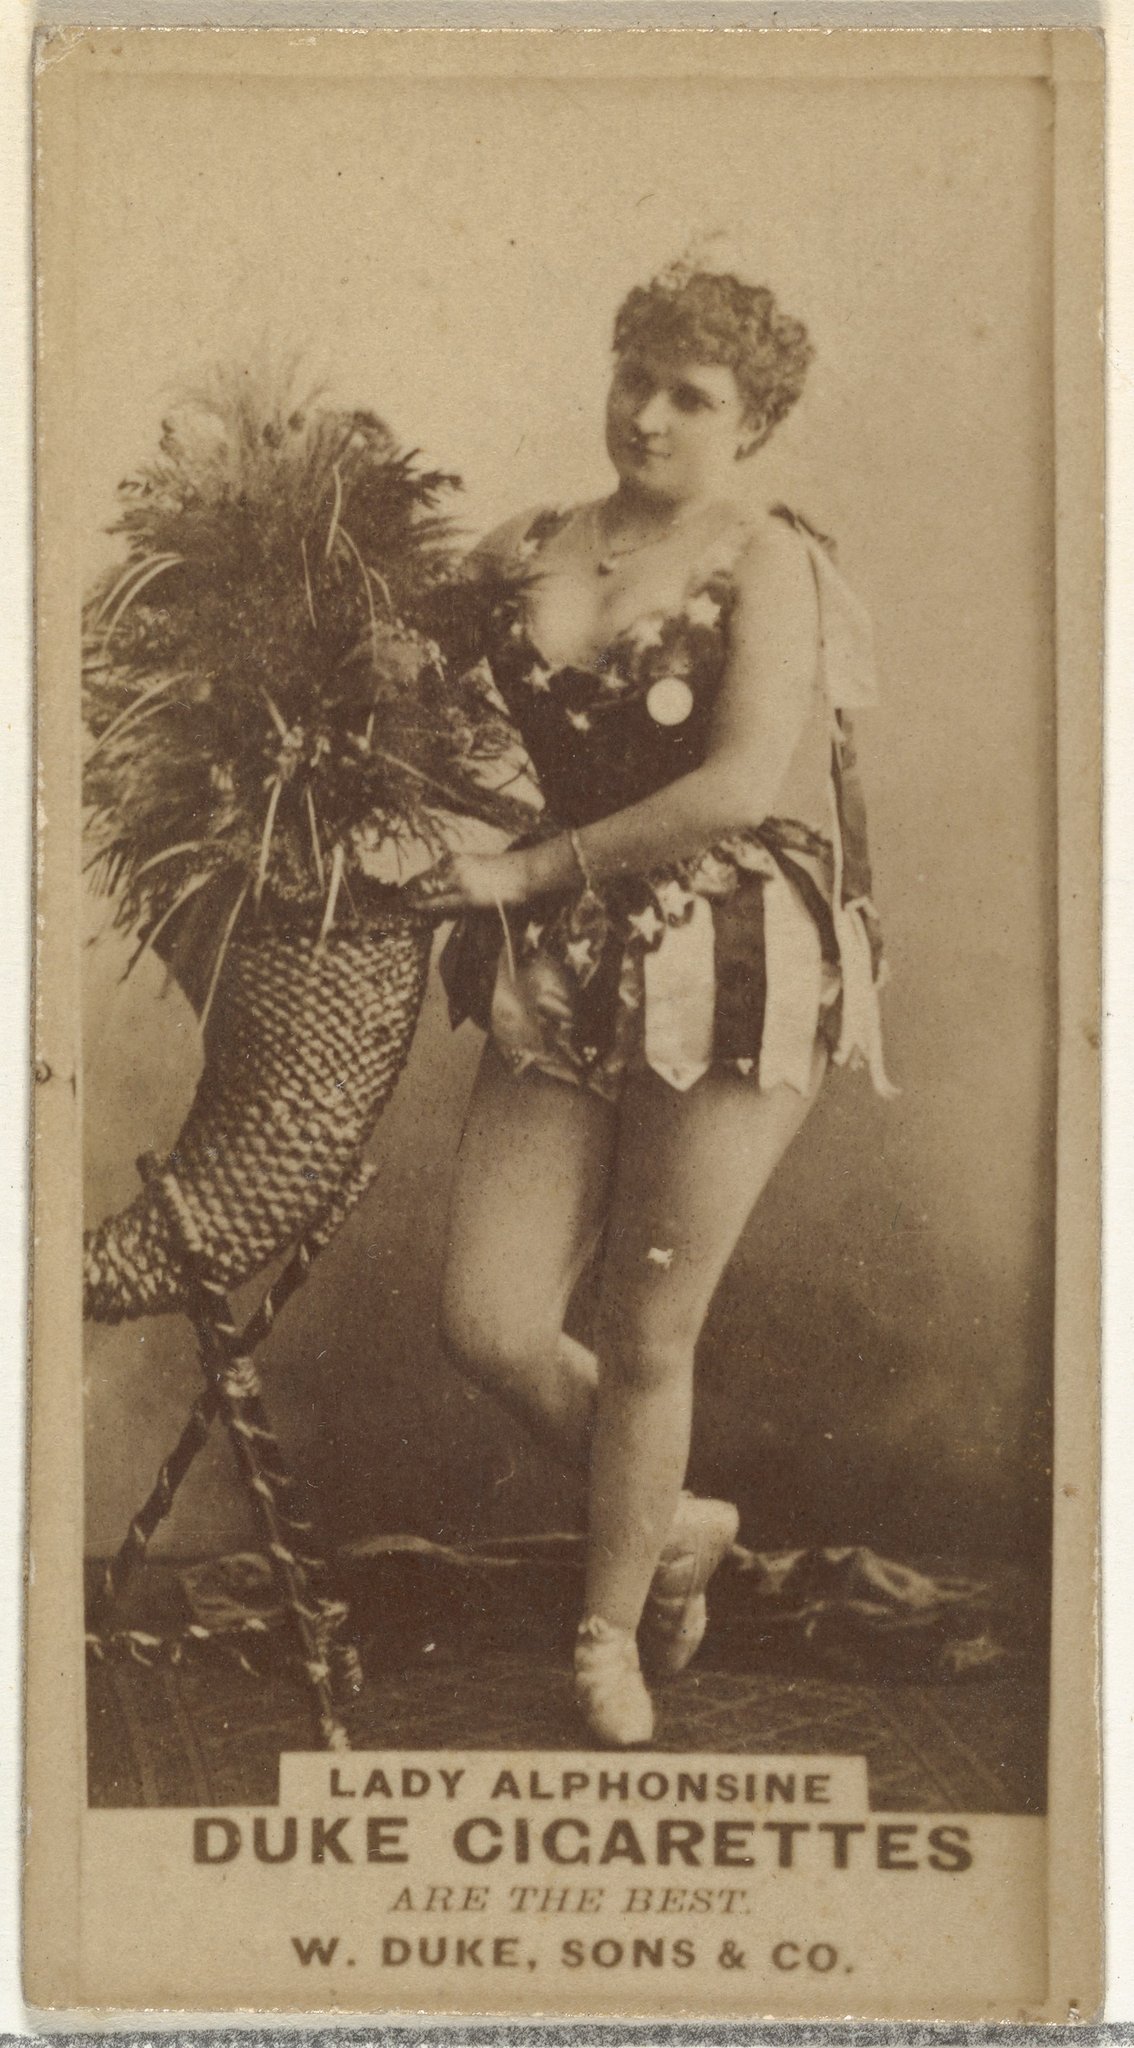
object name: photograph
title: Lady Alphonsine, from the Actors and Actresses series (N145-7) issued by Duke Sons & Co. to promote Duke Cigarettes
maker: w. duke, sons & co.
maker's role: publisher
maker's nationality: american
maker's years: 1870-1920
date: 1880-1889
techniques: albumen silver print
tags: portraits,women,actresses